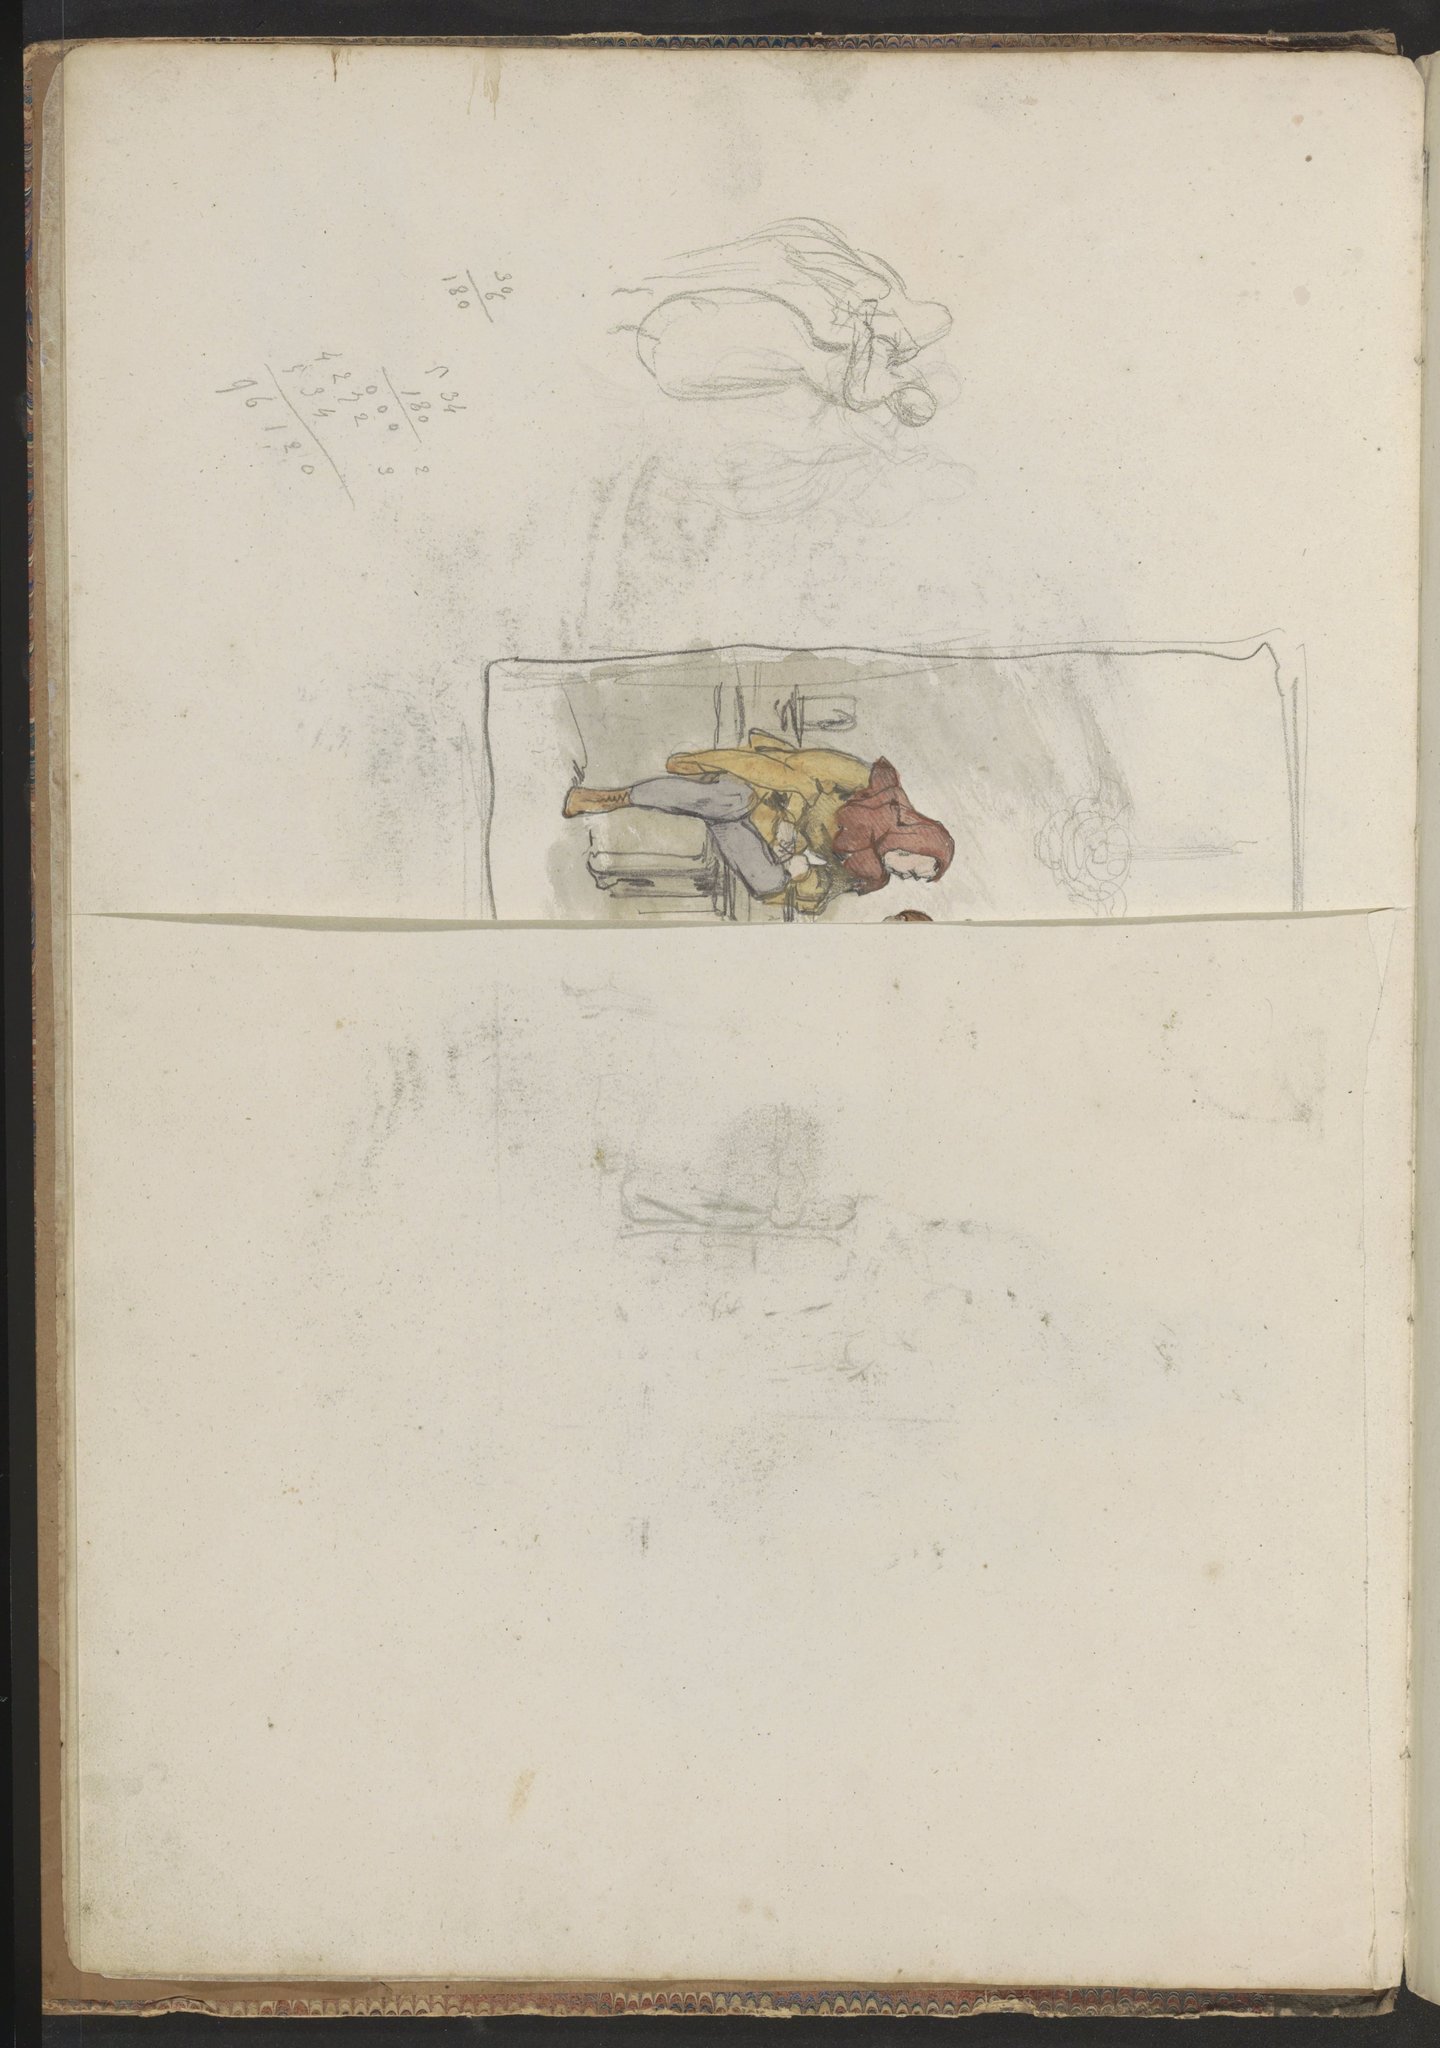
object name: sketchbook leaf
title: Zittende man op een bank en figuren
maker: johannes huybertus van hove bzn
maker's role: print maker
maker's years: 1827-1881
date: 1837-1881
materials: paper, pencil, watercolor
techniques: brush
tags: sitting figure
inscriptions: annotation: ‘[...]’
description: Blad 4 verso uit een schetsboek met 33 bladen en 10 losse tekeningen.